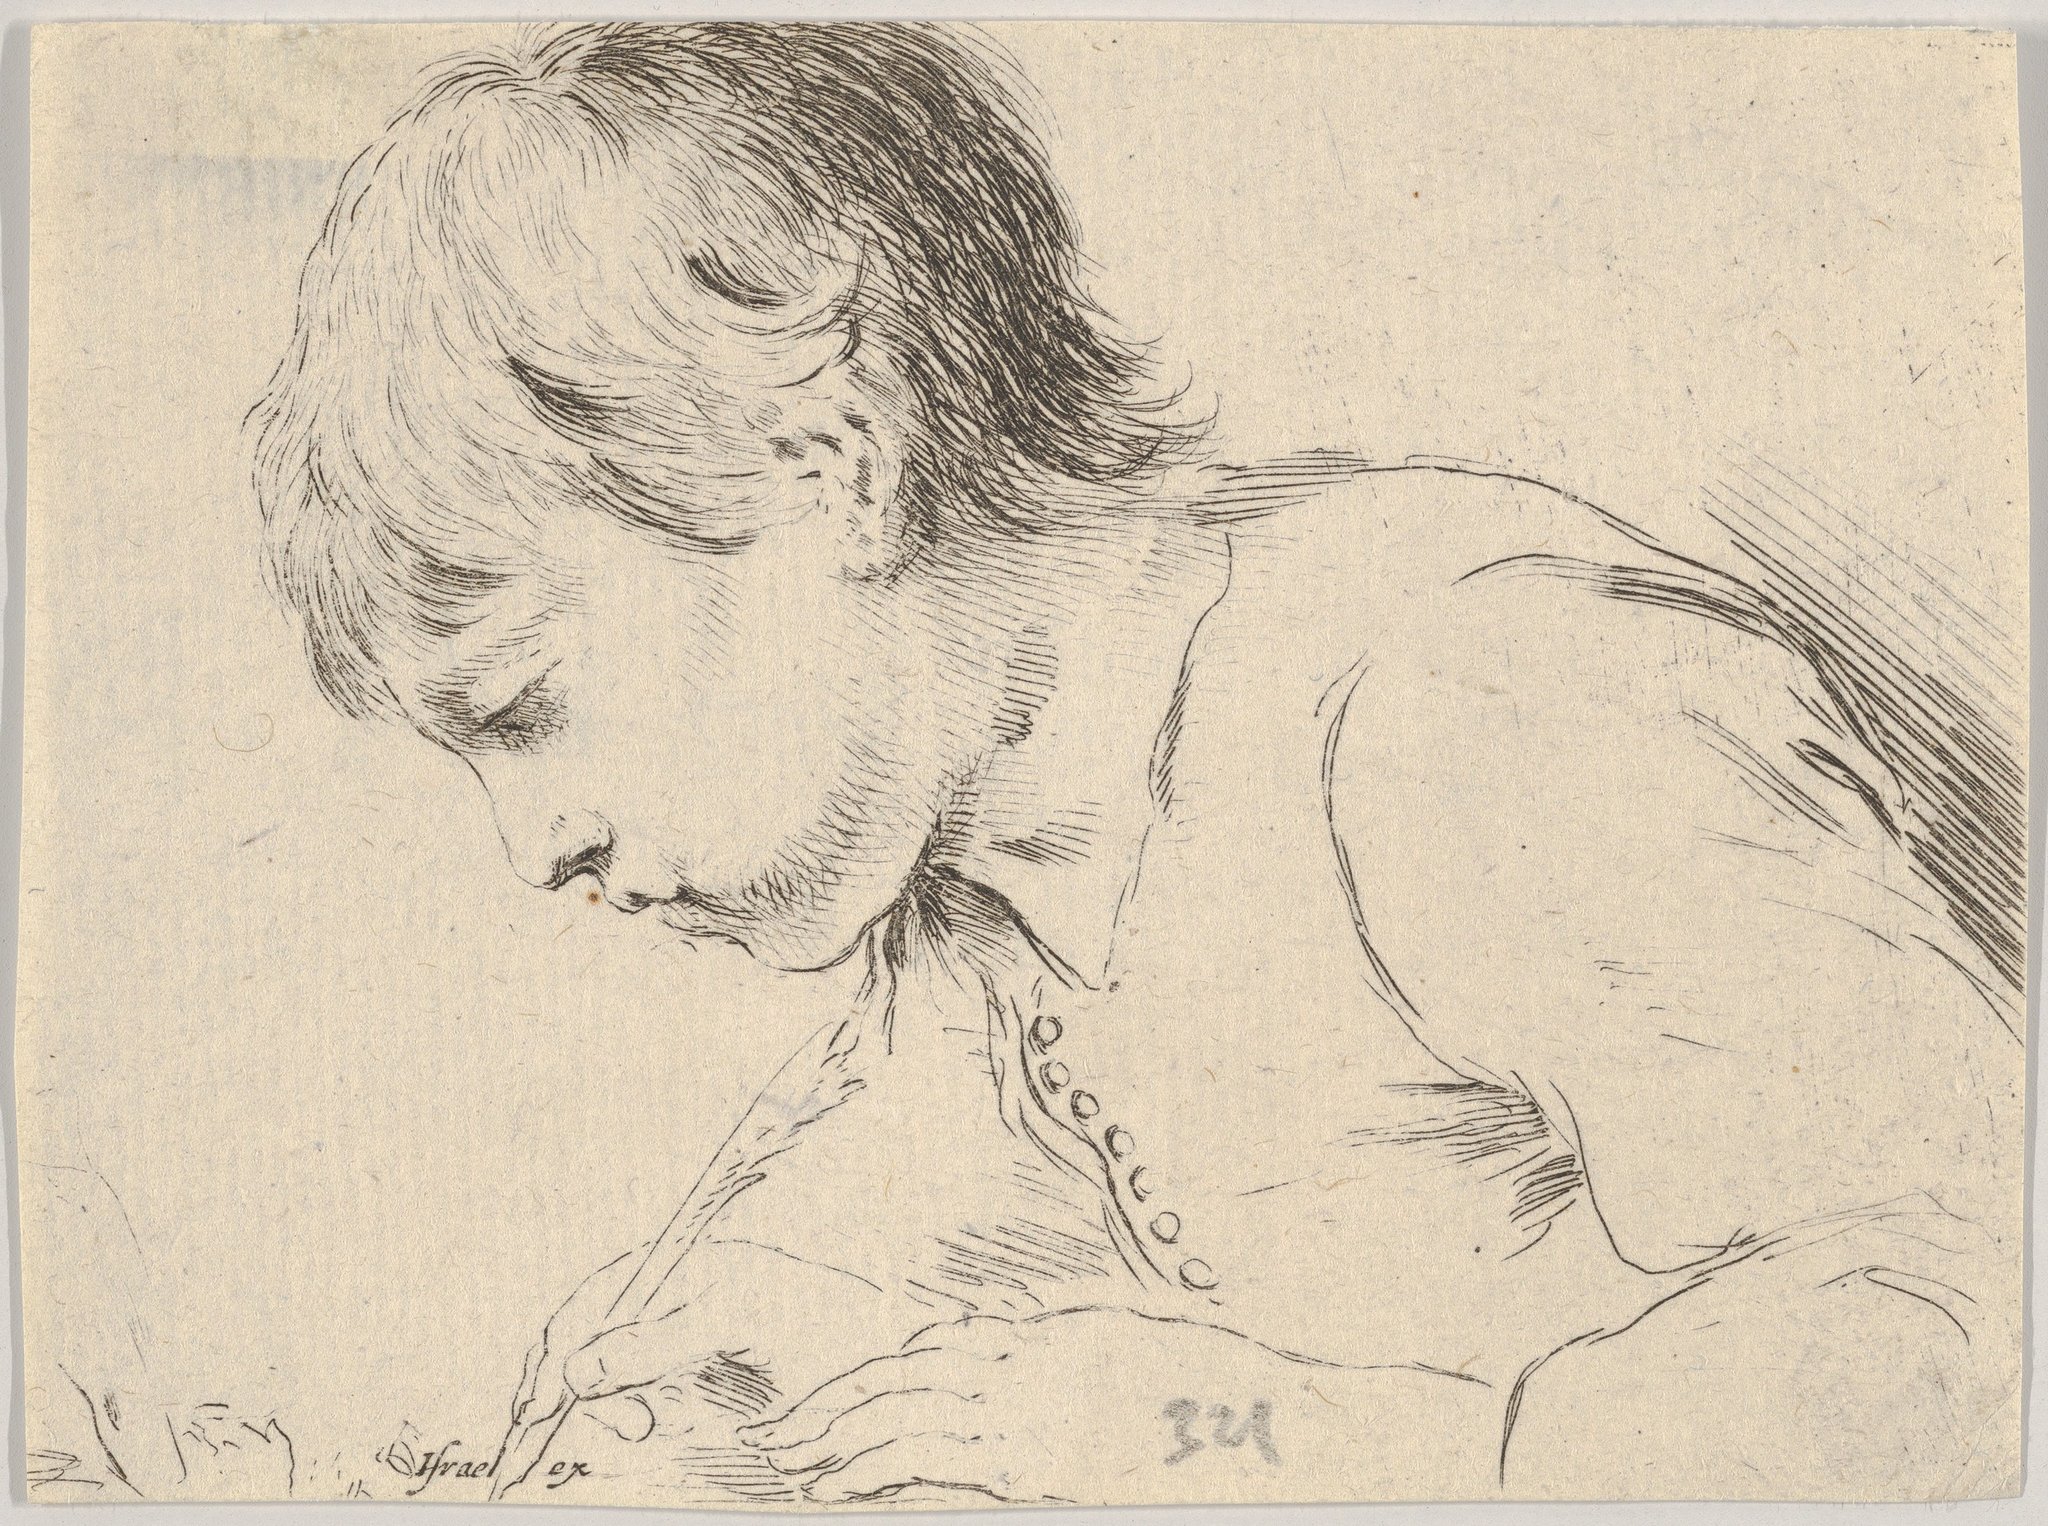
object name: print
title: Plate 14: A child writing with a quill, facing left in profile, from "Various heads and figures" (Diverses têtes et figures)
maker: stefano della bella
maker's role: artist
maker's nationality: italian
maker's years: 1610-1664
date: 1650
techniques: etching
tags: boys,profiles,writing